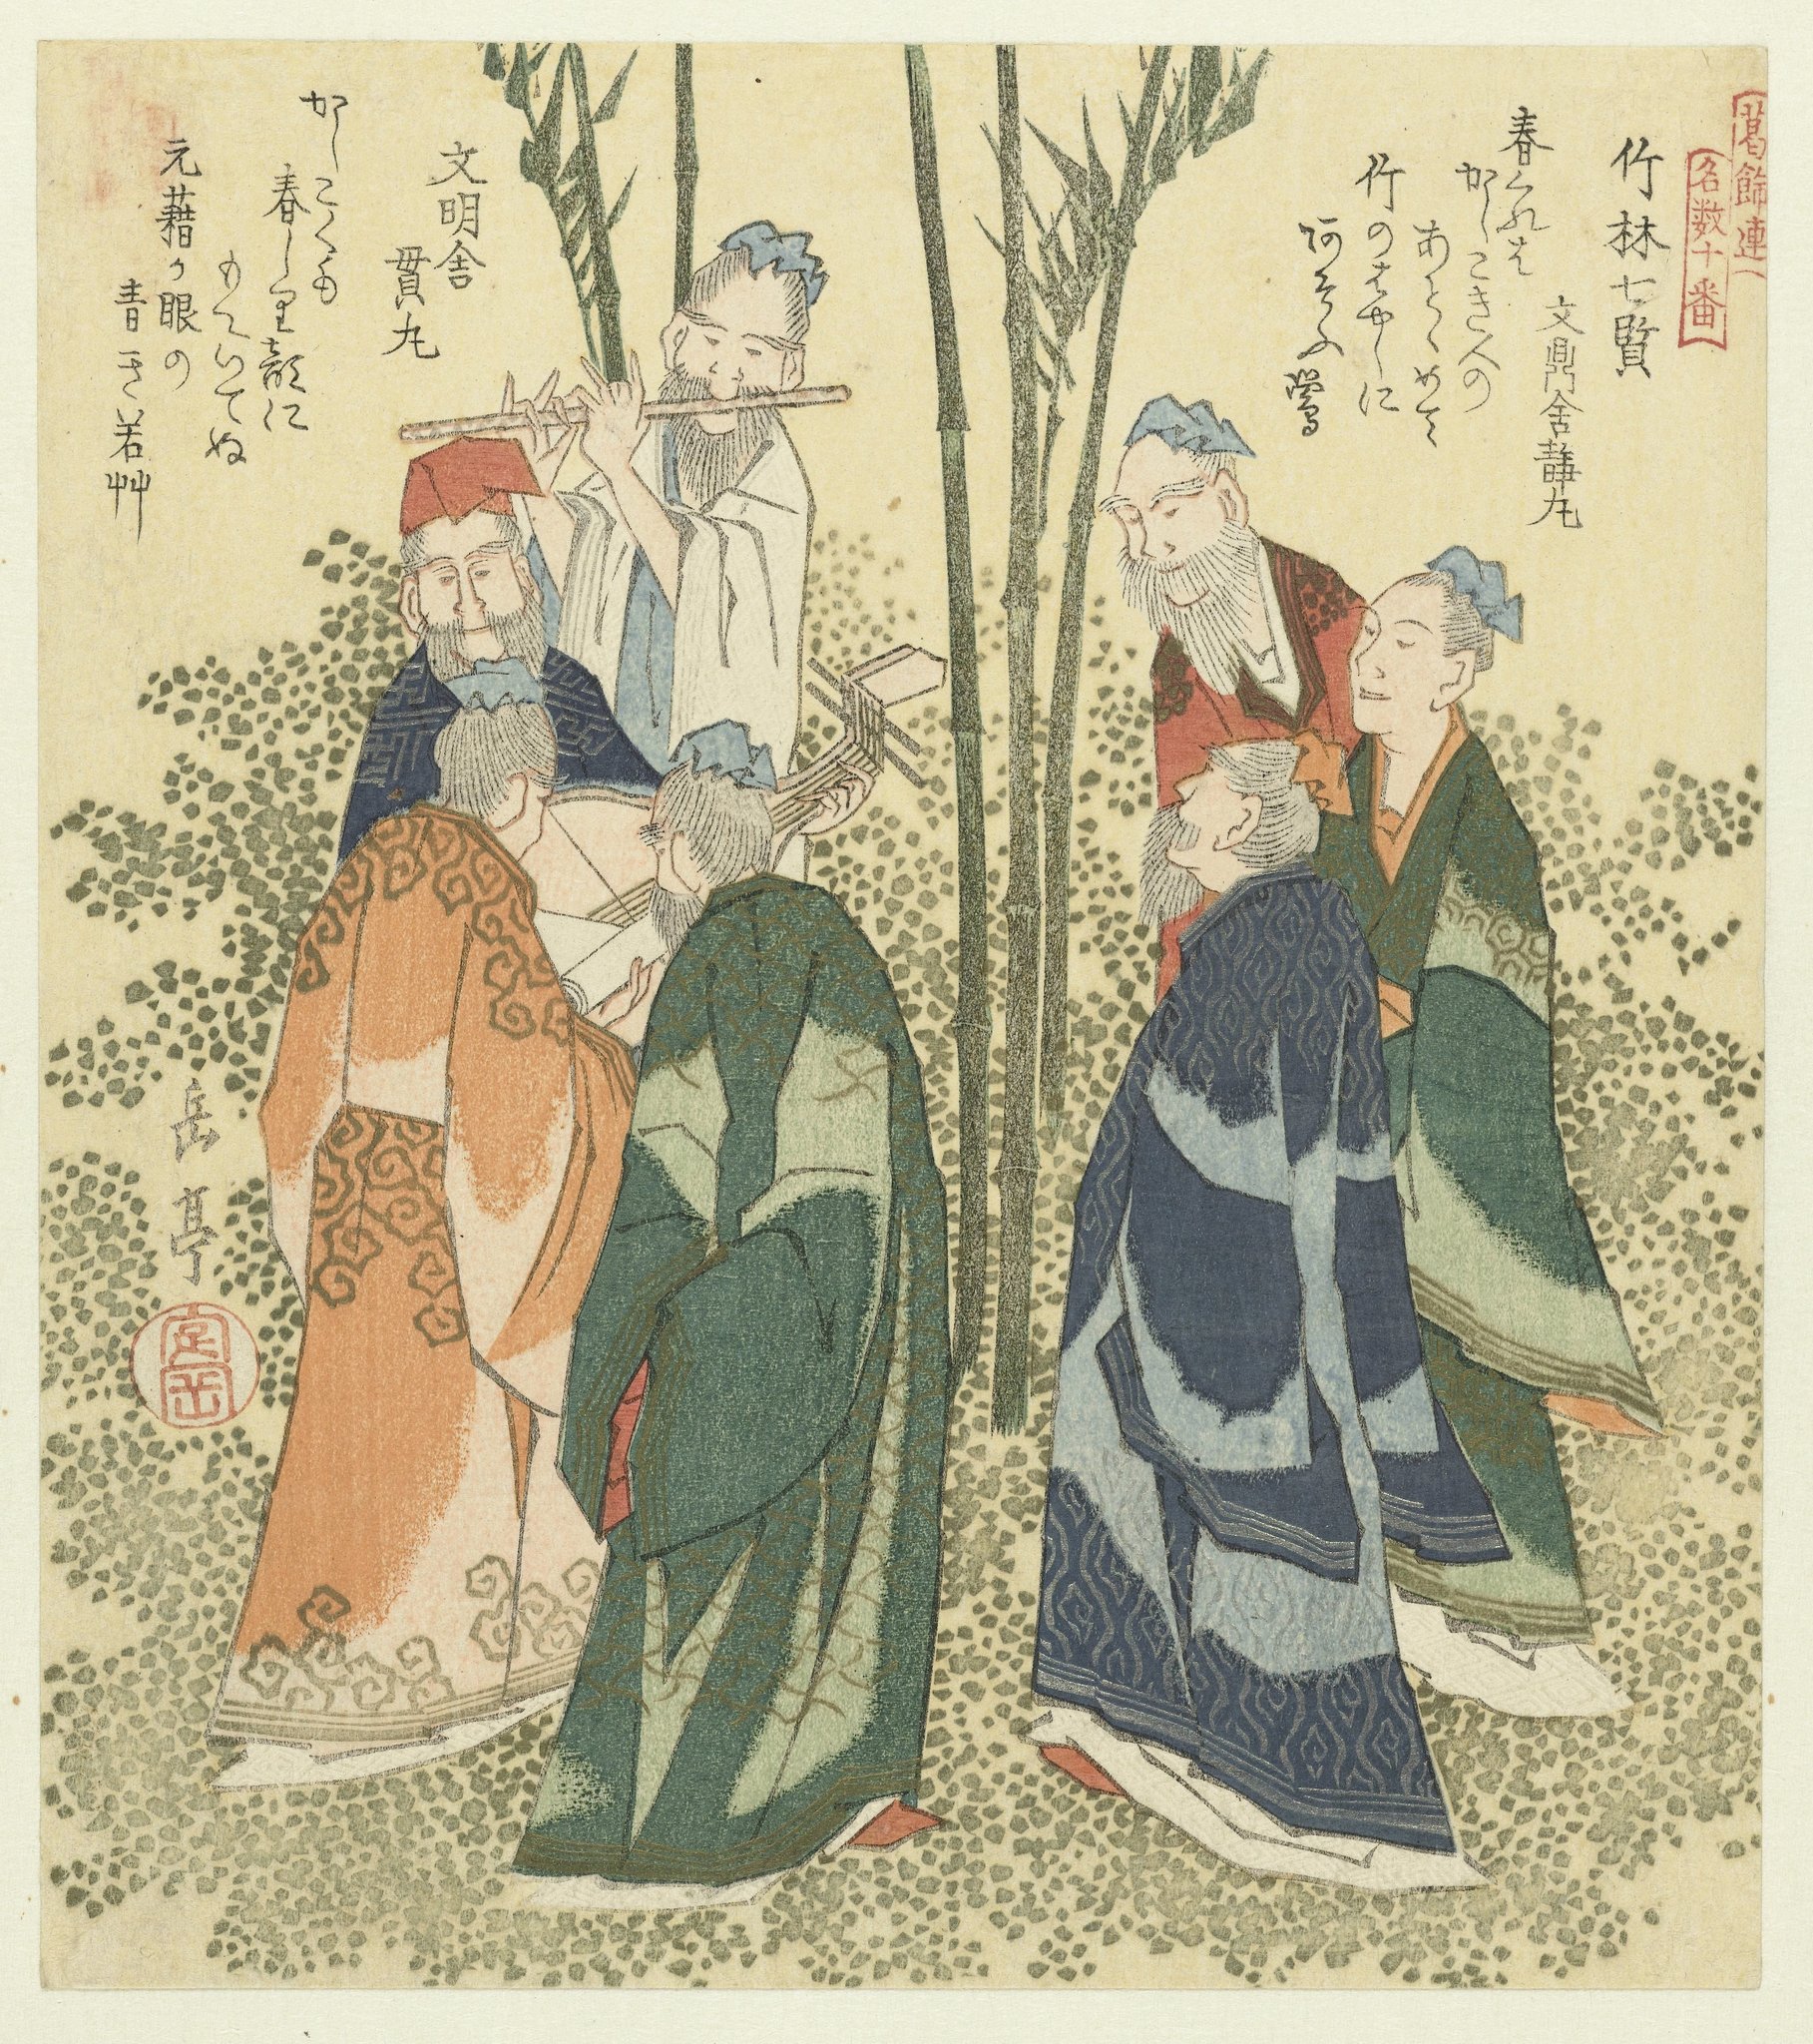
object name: surimono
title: De zeven wijsgeren van het bamboe bos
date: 1828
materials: paper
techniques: woodcut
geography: japan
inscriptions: collector's mark, verso, stamped: Lugt 2228, collector's mark, passe-partout, bottom left, printed: JABdH with a rooster.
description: Een surimono is een luxe uitgevoerde prent waarop beeld met één of meerdere gedichten gecombineerd is. Bij het drukken van een surimono werd vaak gebruik gemaakt van dikker papier, blinddruk en metaal pigmenten, zoals koper- en zilverpoeder. De prenten werden vaak in opdracht van dichters gemaakt en als exclusief geschenk aan vrienden en relaties gegeven.